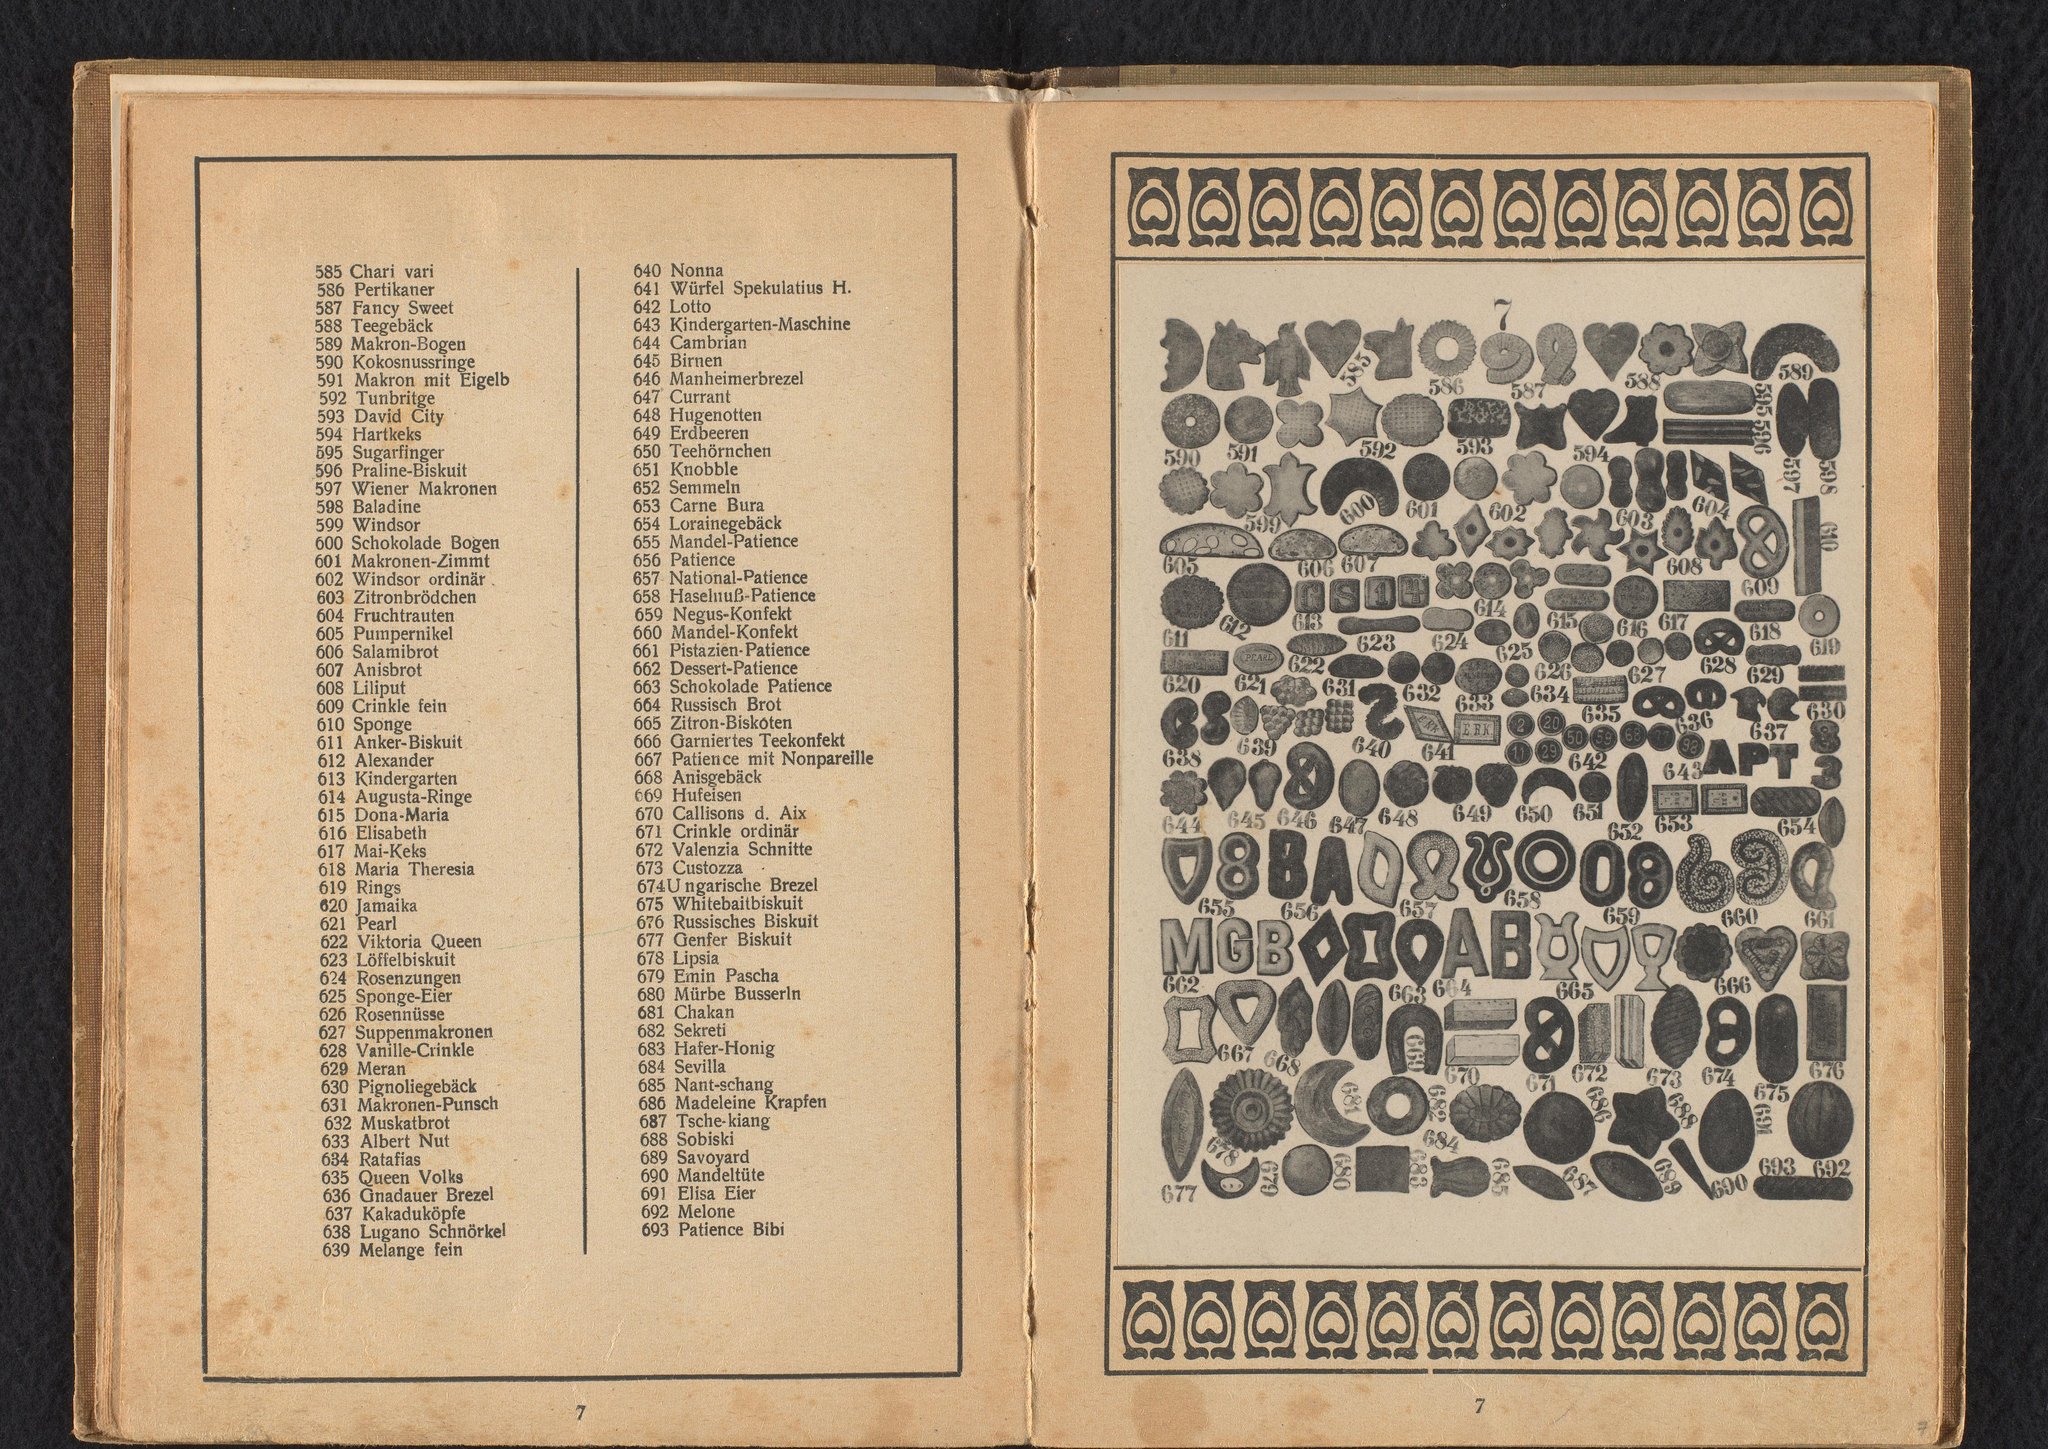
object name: page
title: Verschillende Engelse koekjes en biscuits als voorbeeld bij recepten 585-693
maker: Anonymous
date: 1900-1905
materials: paper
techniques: photograph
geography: bad langensalza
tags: pastry cook, moulds for biscuits, biscuits